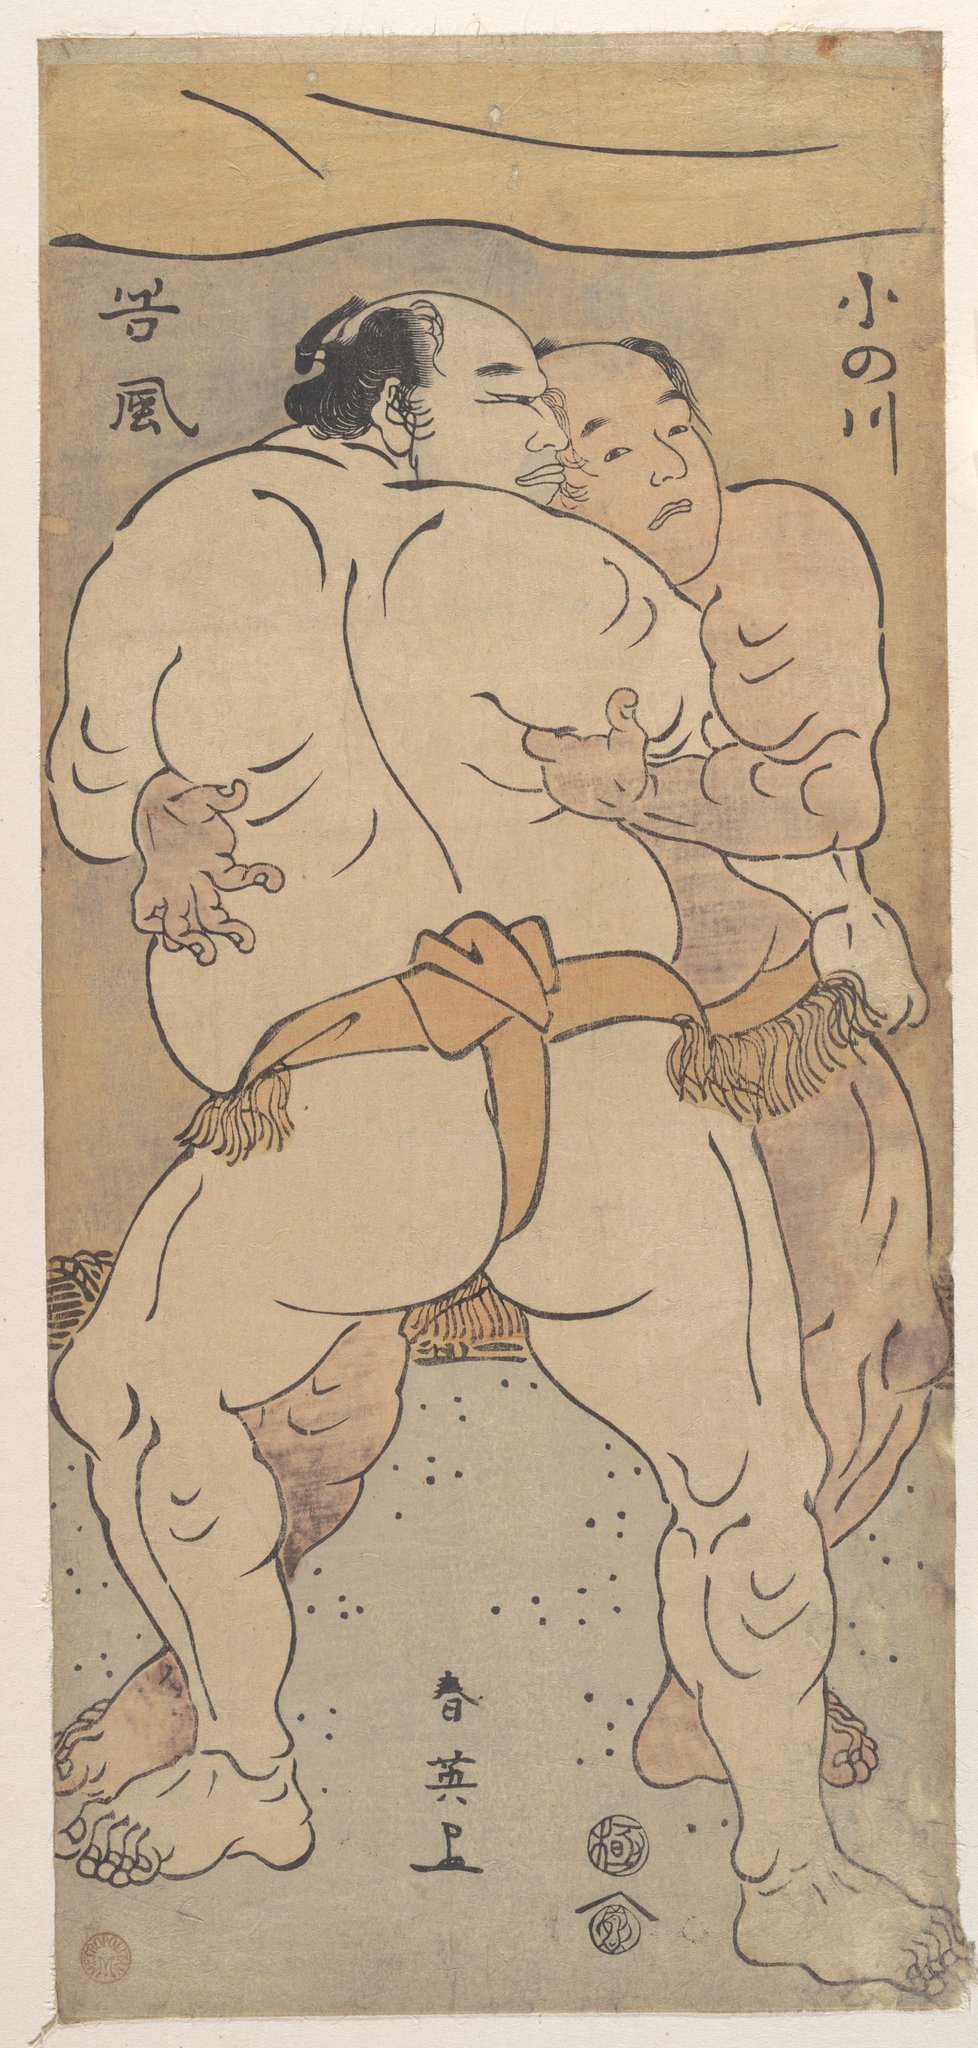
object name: print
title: Two Famous Wrestlers Onogawa and Tanikase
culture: japanese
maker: katsukawa shun'ei 勝川春英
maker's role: artist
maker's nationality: japanese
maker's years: 1762-1819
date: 1795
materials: ink, paper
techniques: woodblock print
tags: men,athletes,wrestling